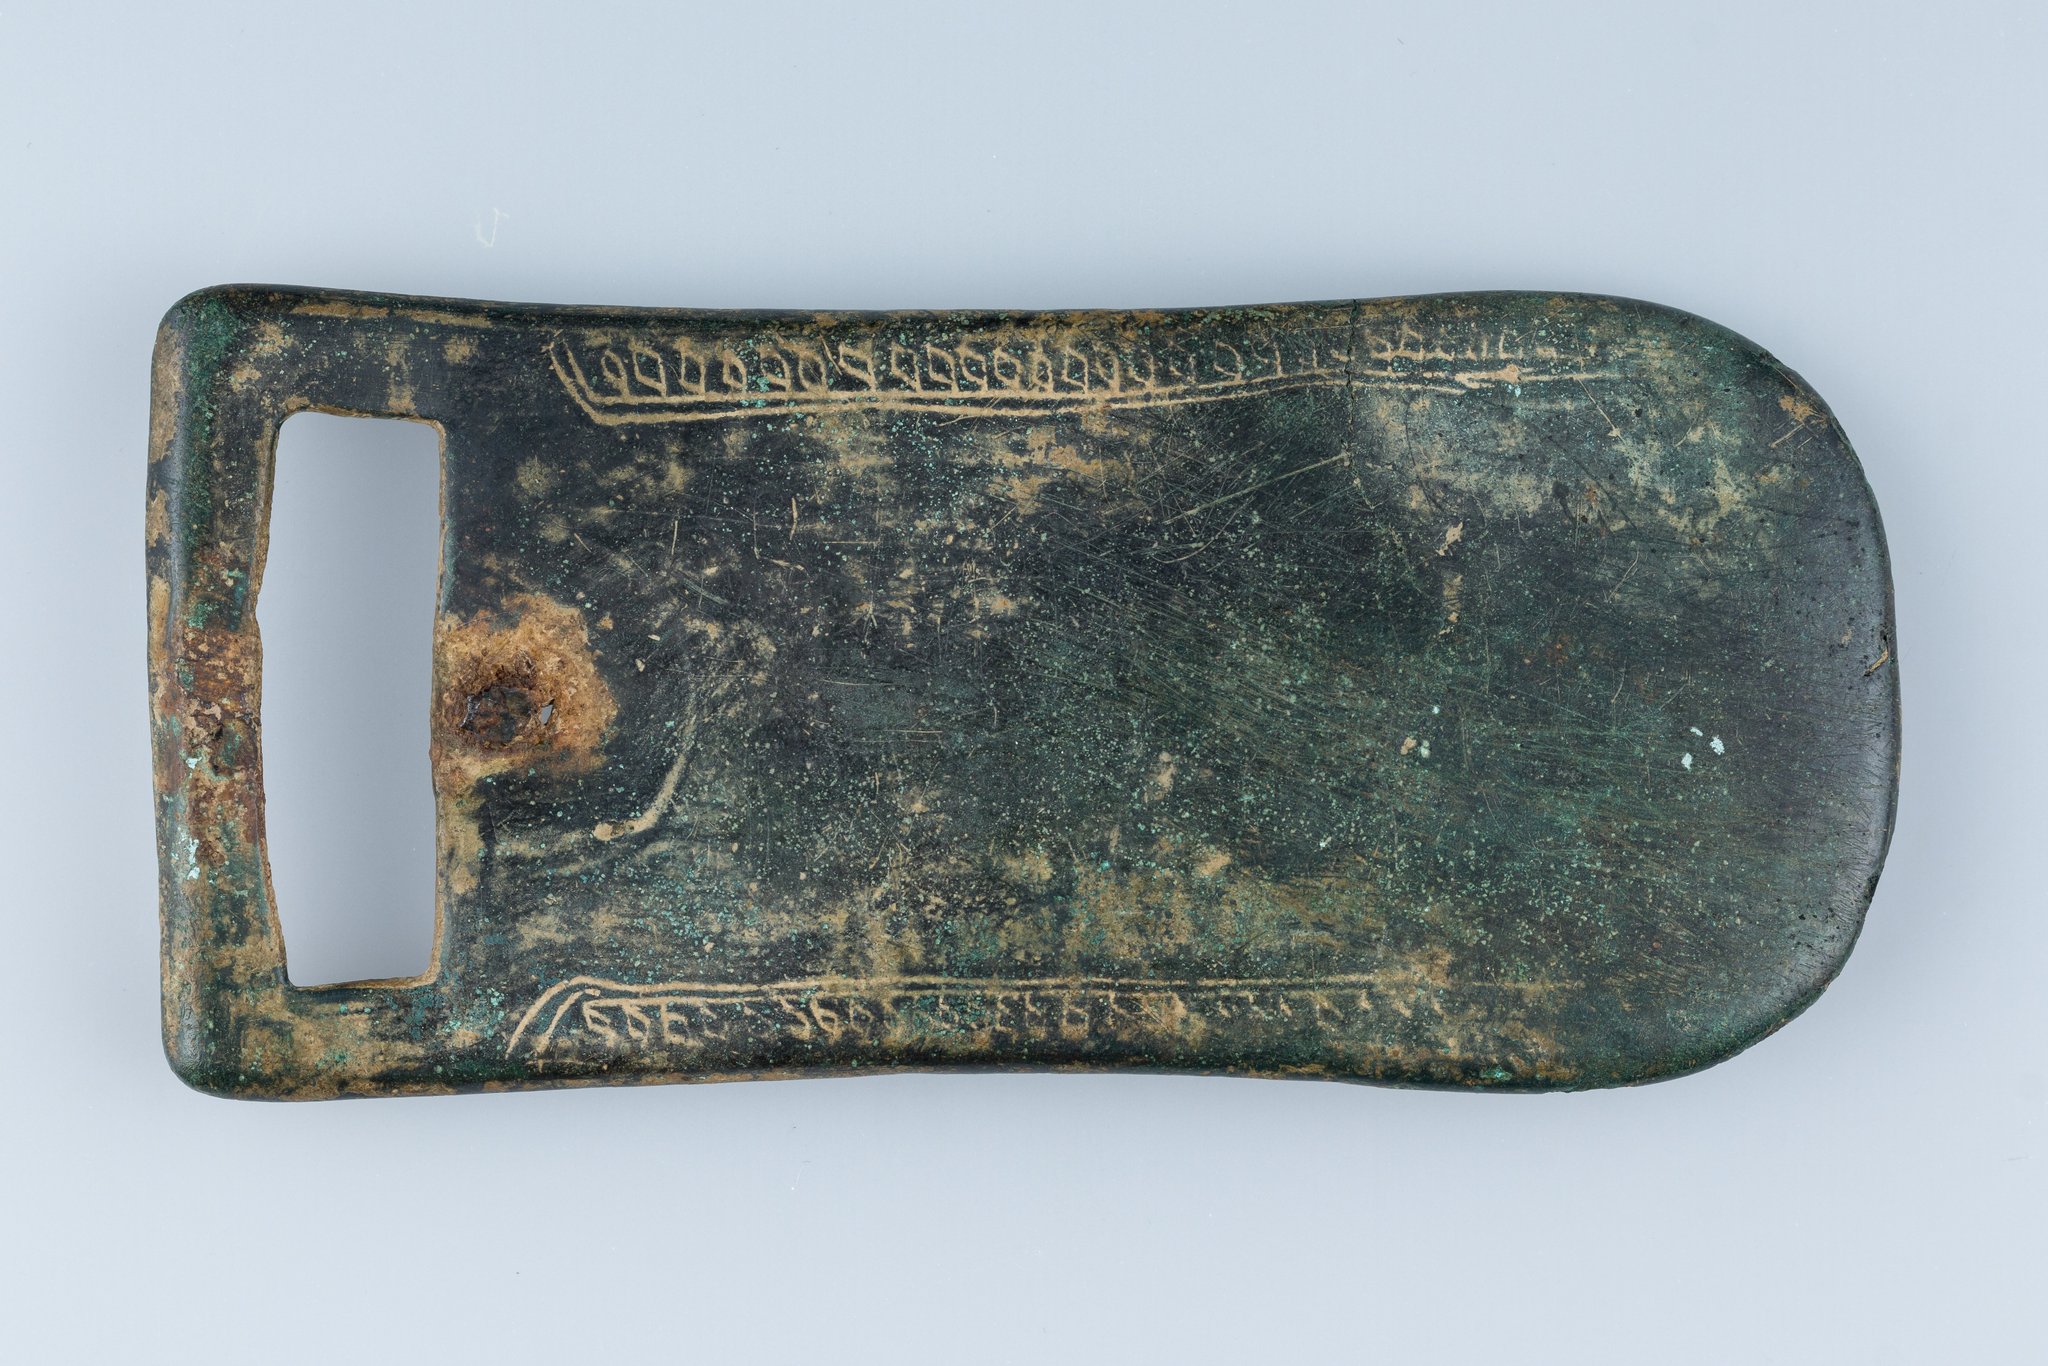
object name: buckle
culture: visigothic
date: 567-633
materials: copper alloy, iron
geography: spain or portugal